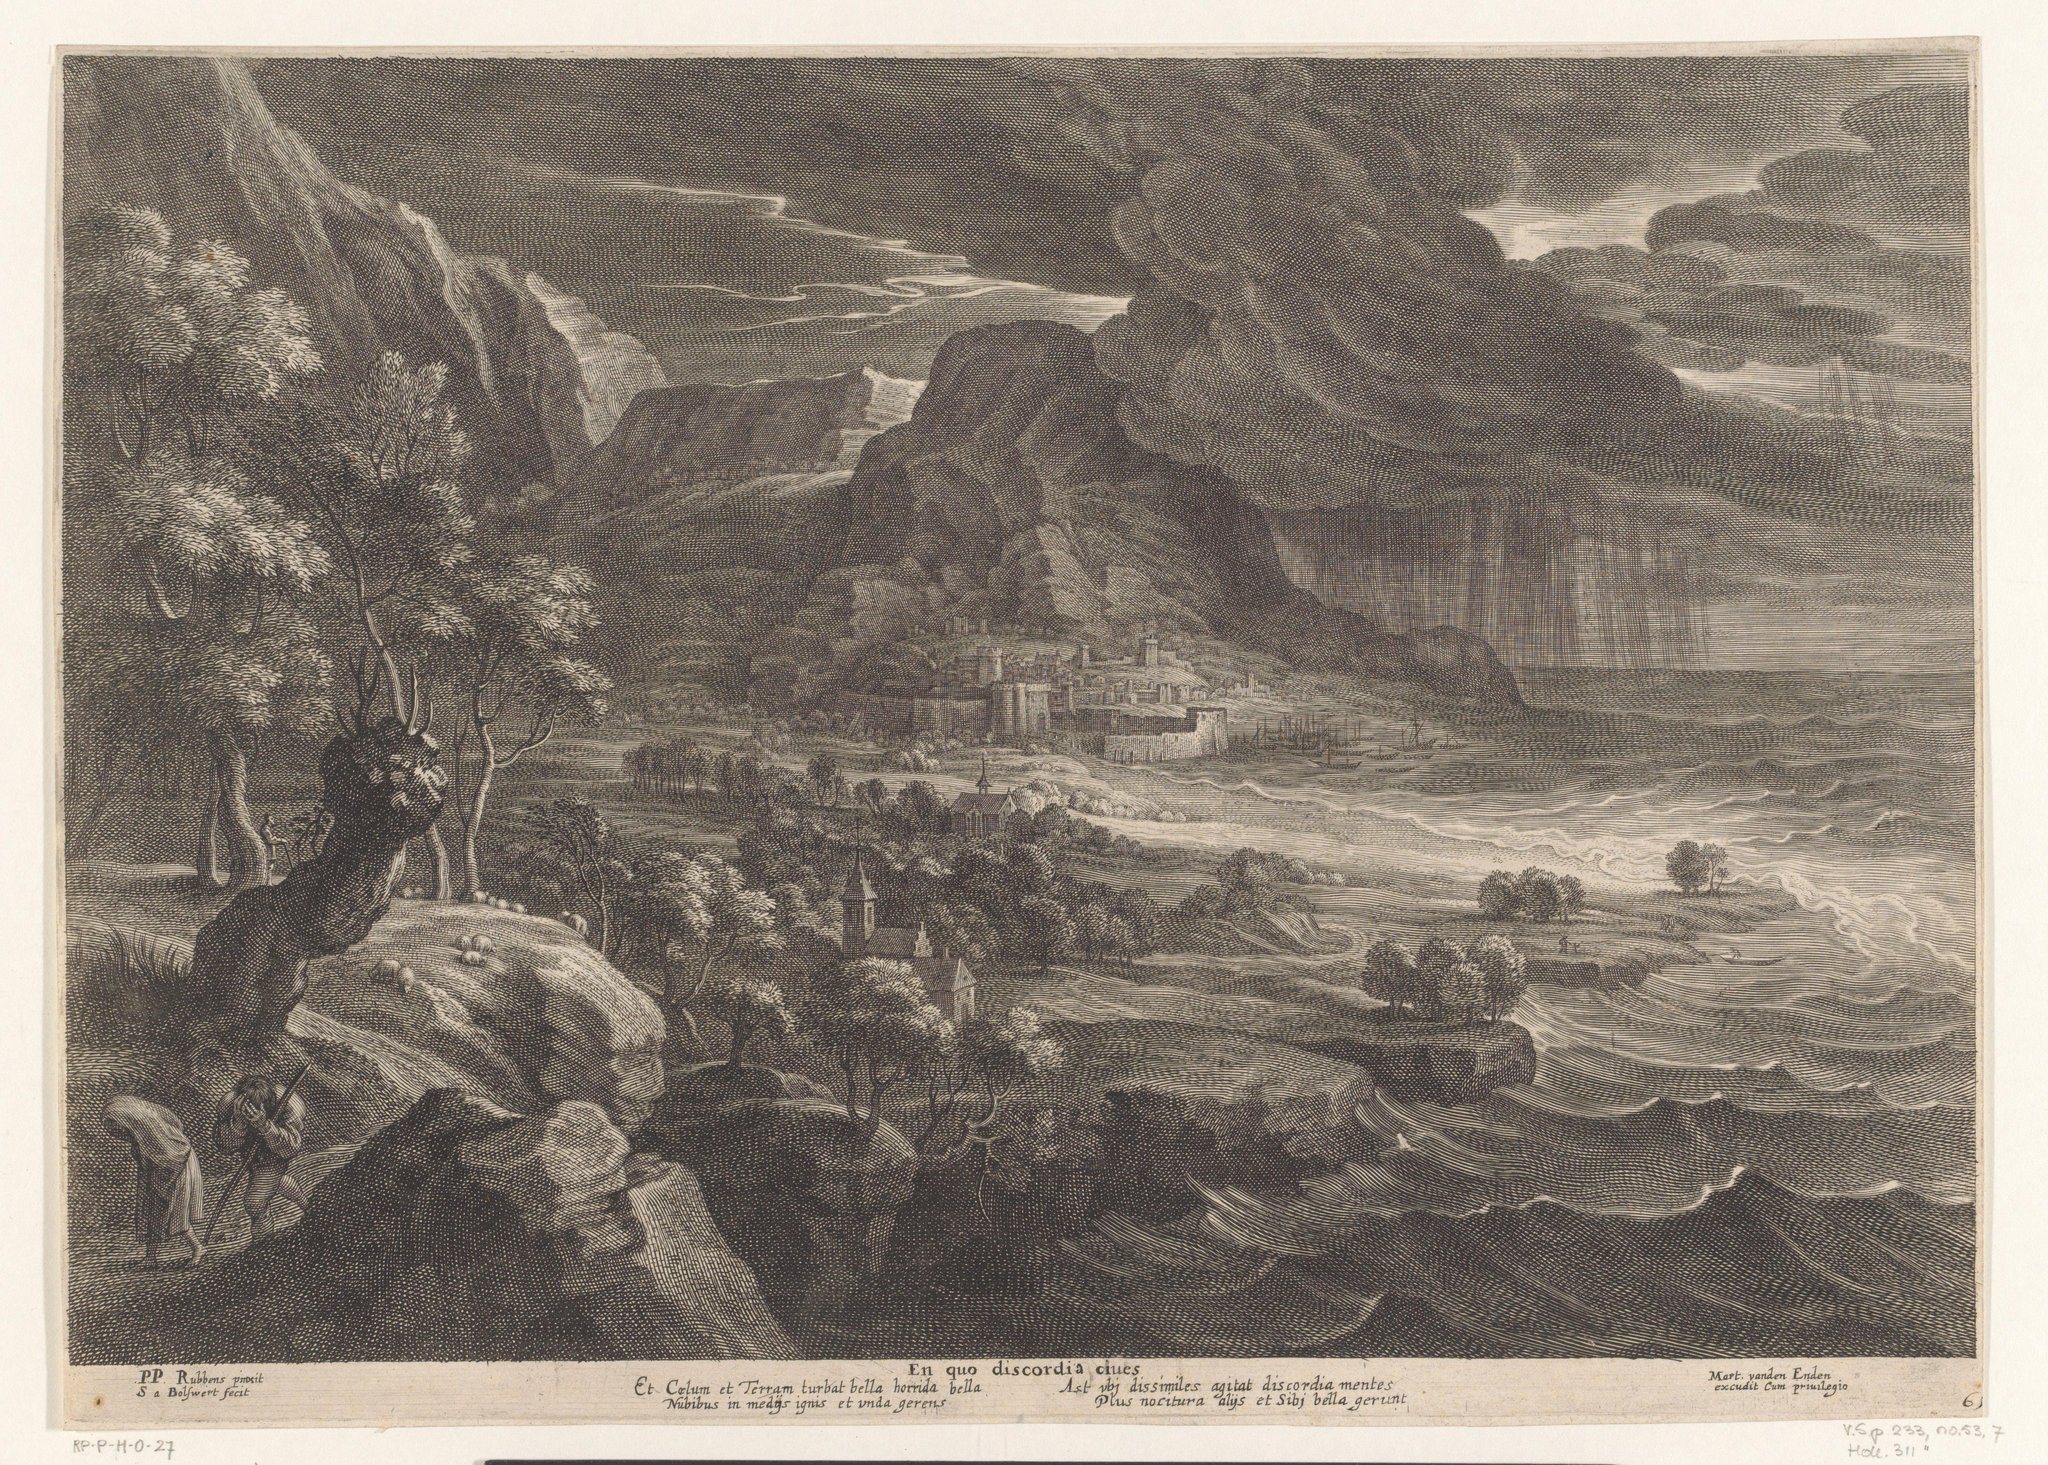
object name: print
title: Landschap aan de kust met onweer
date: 1596-1659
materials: paper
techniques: engraving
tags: thunderstorm, coast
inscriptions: collector's mark: Lugt 10, inscription: ‘B 29 39-58’, collector's mark: Lugt 11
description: Prent naar schilderij van Peter Paul Rubens. Hollstein beschrijft een serie kleine landschappen onder de nrs. 305 t/m 325 maar deze prenten zijn niet als reeks vervaardigd.